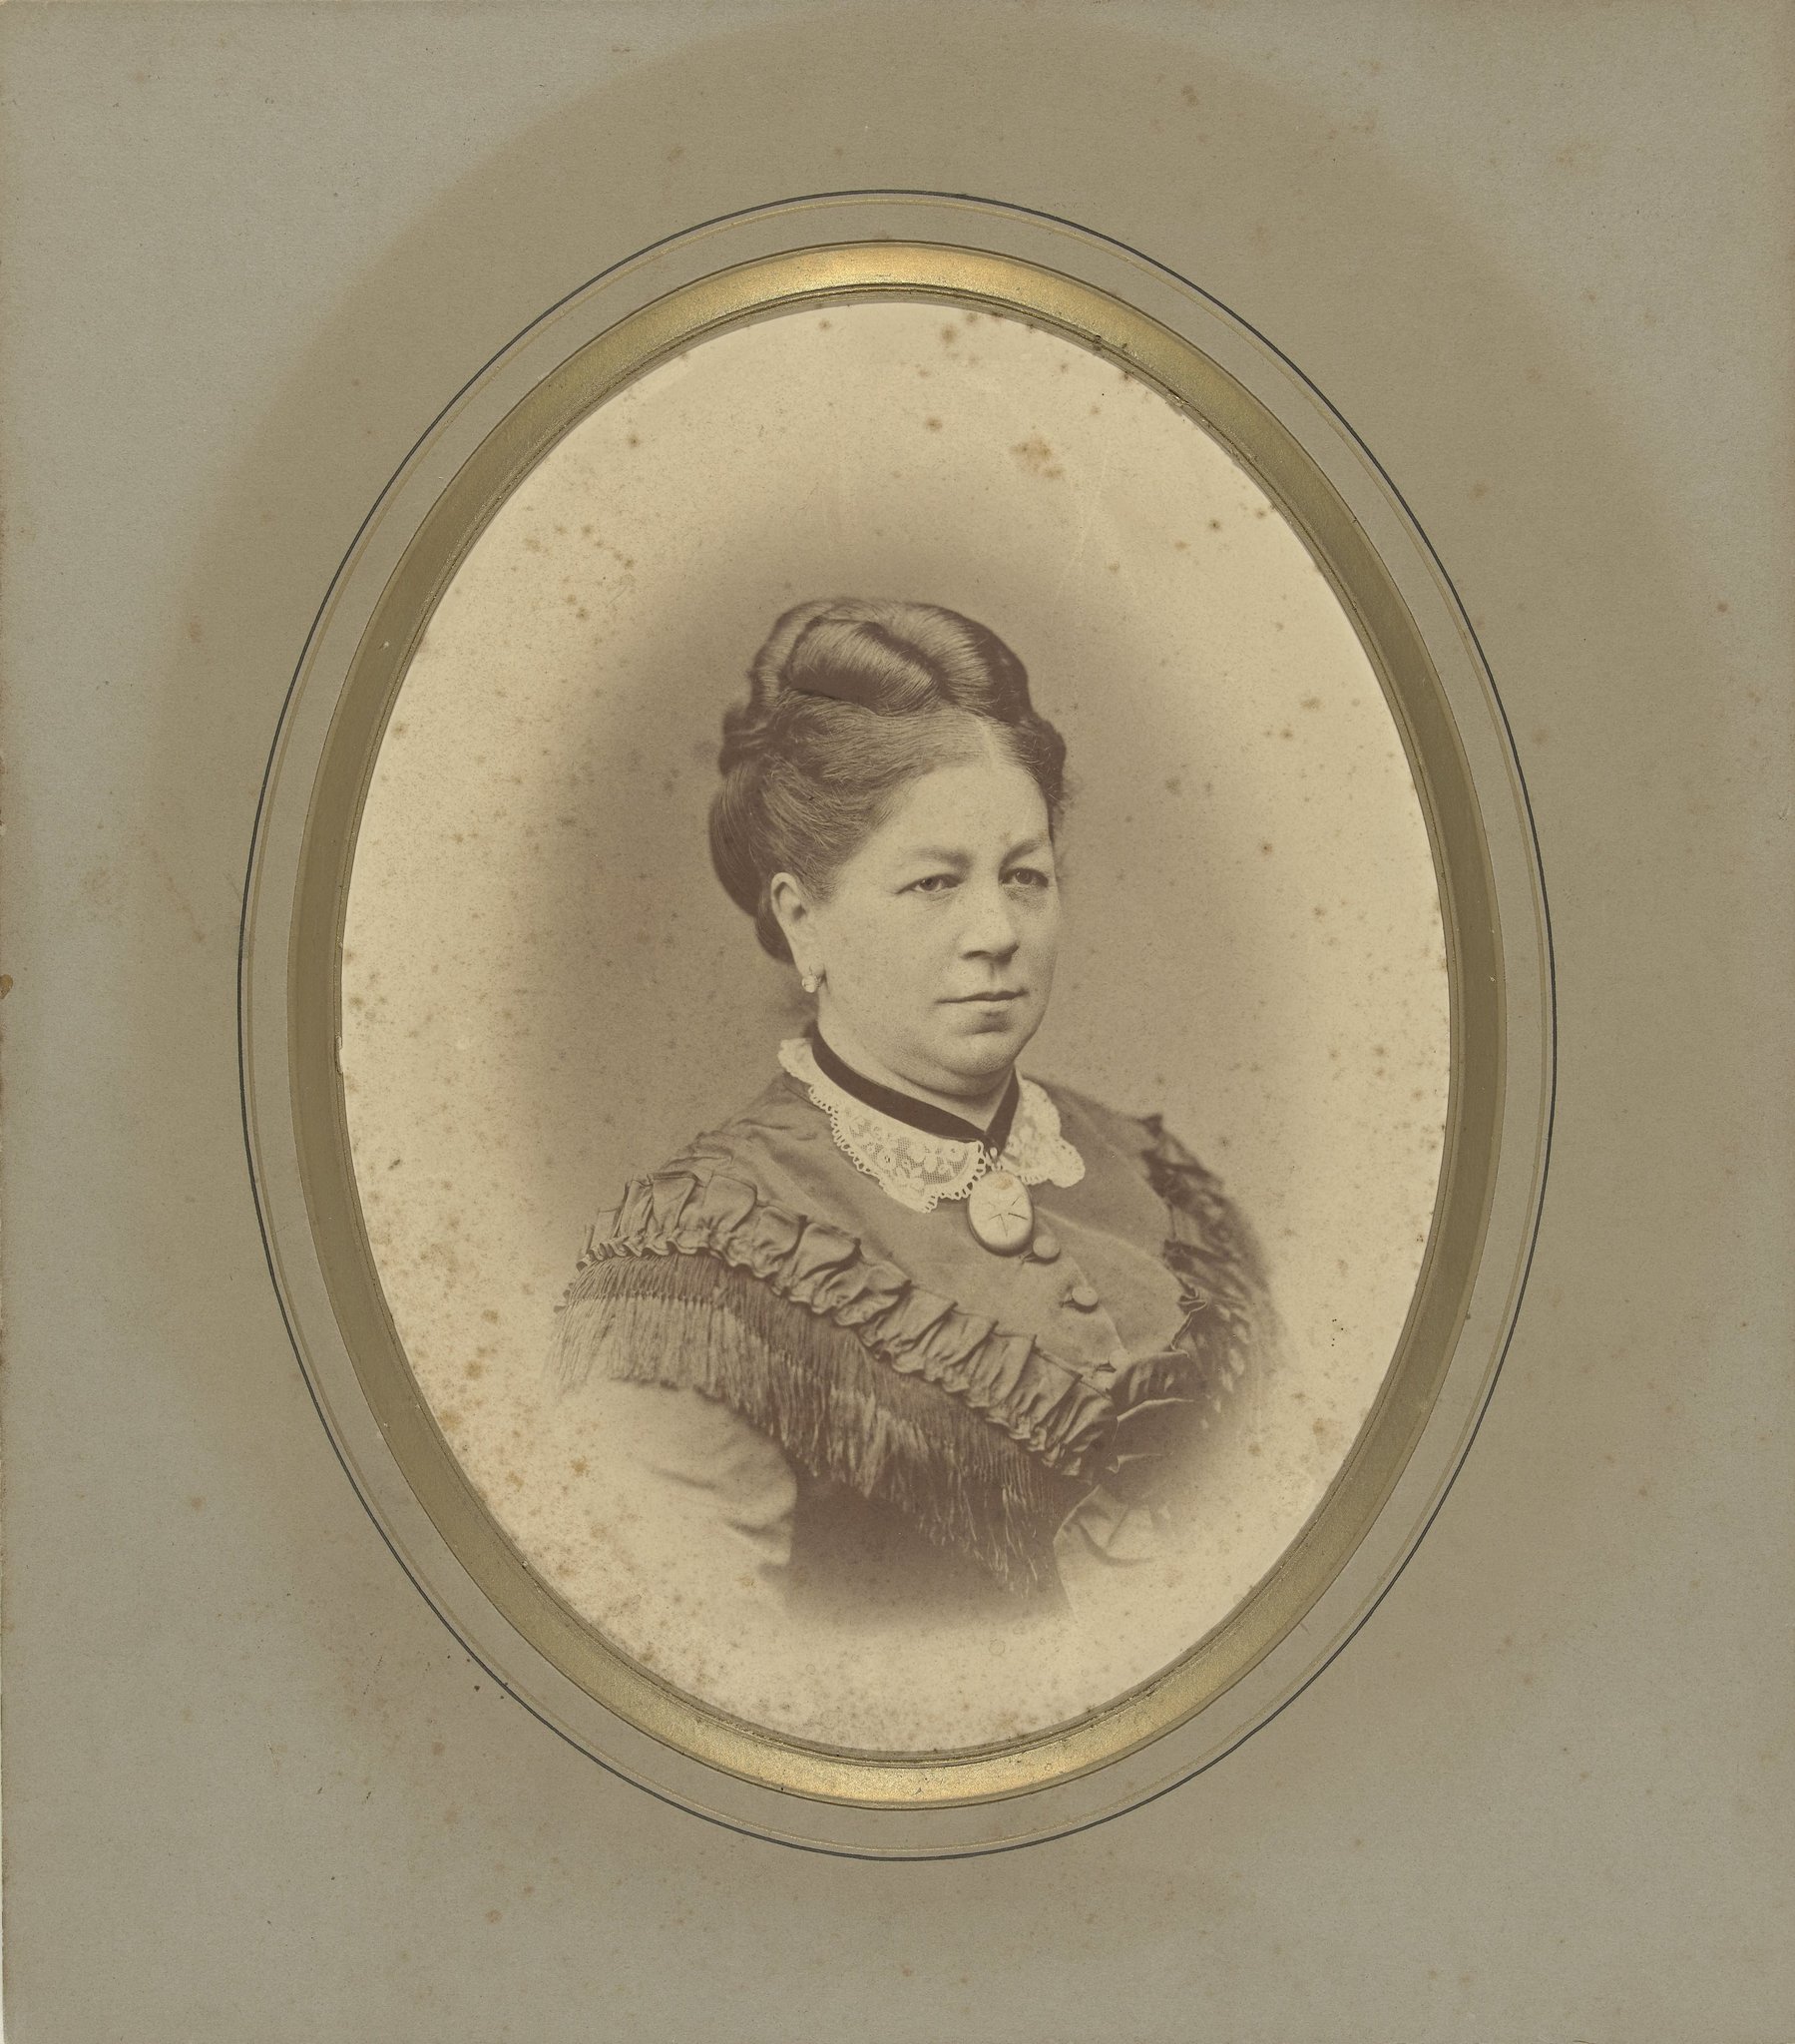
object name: photograph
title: Portret van een vrouw met medaillon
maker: Anonymous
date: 1870-1890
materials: cardboard, photographic support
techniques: albumen print